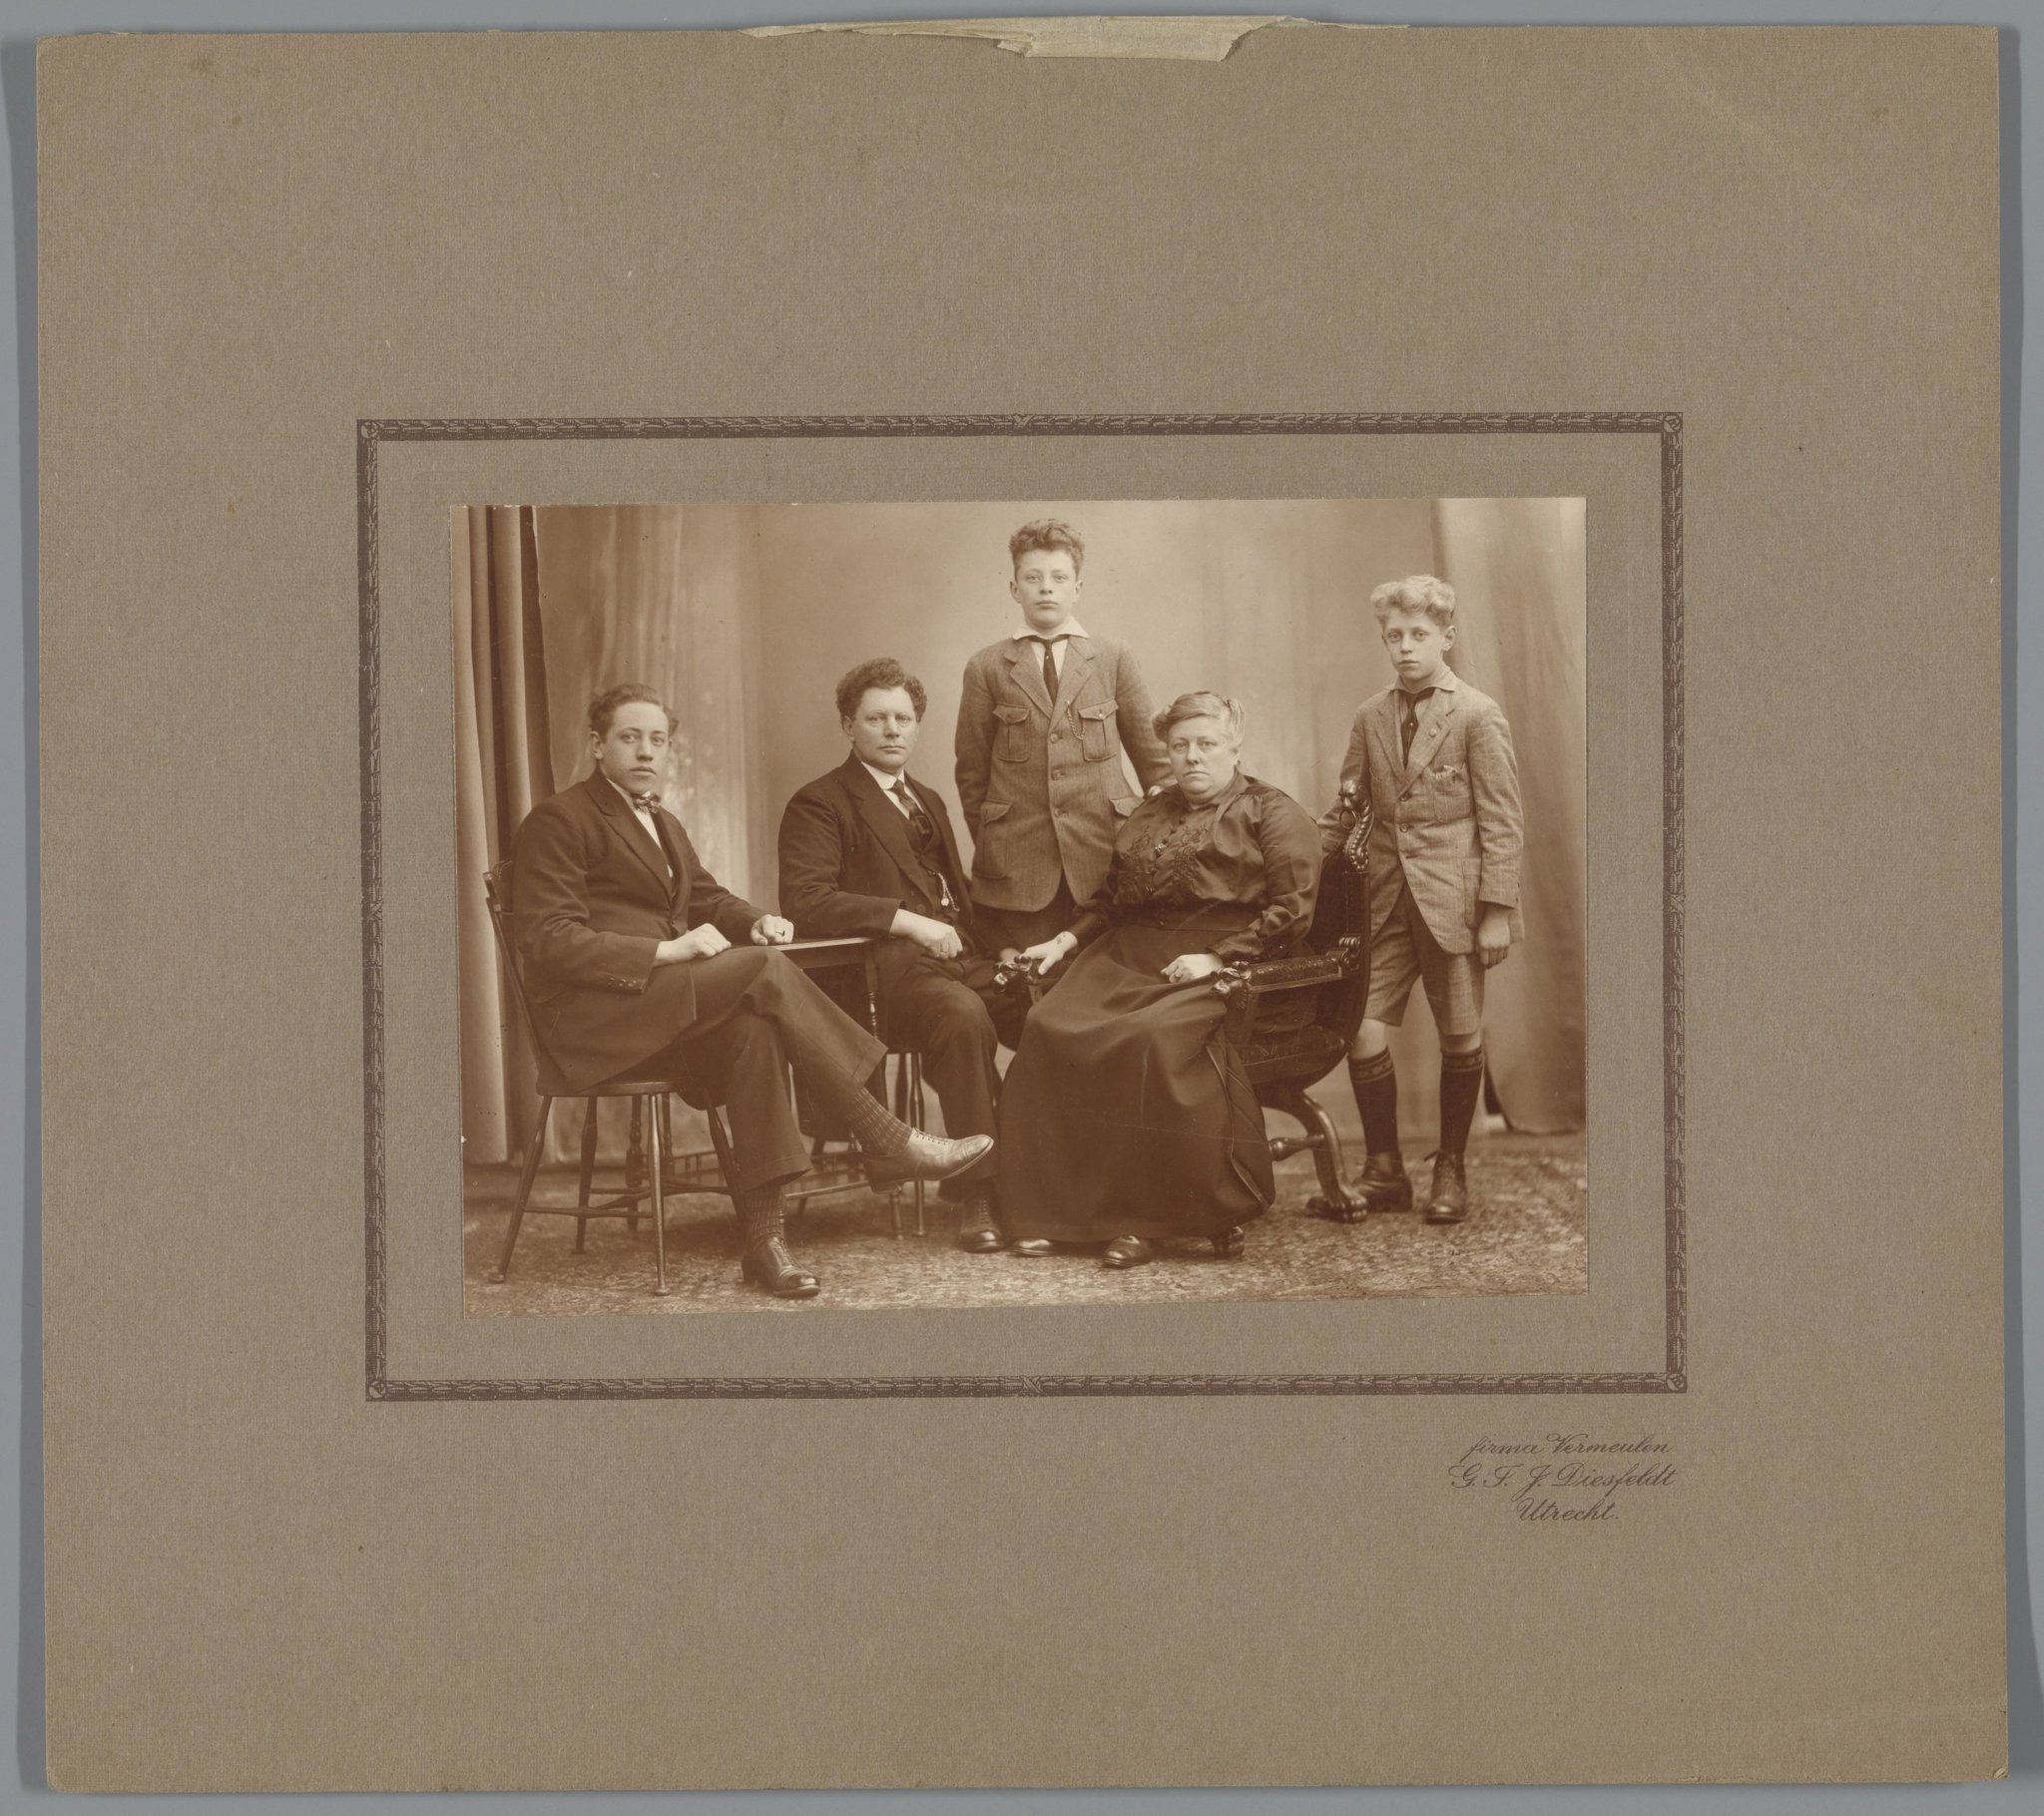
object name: photograph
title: Echtpaar met drie kinderen (Utrecht)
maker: willem witsen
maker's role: draughtsman, painter, print maker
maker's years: 1860-1923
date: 1860-1915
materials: paper, photographic support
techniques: gelatin silver print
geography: utrecht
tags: utrecht